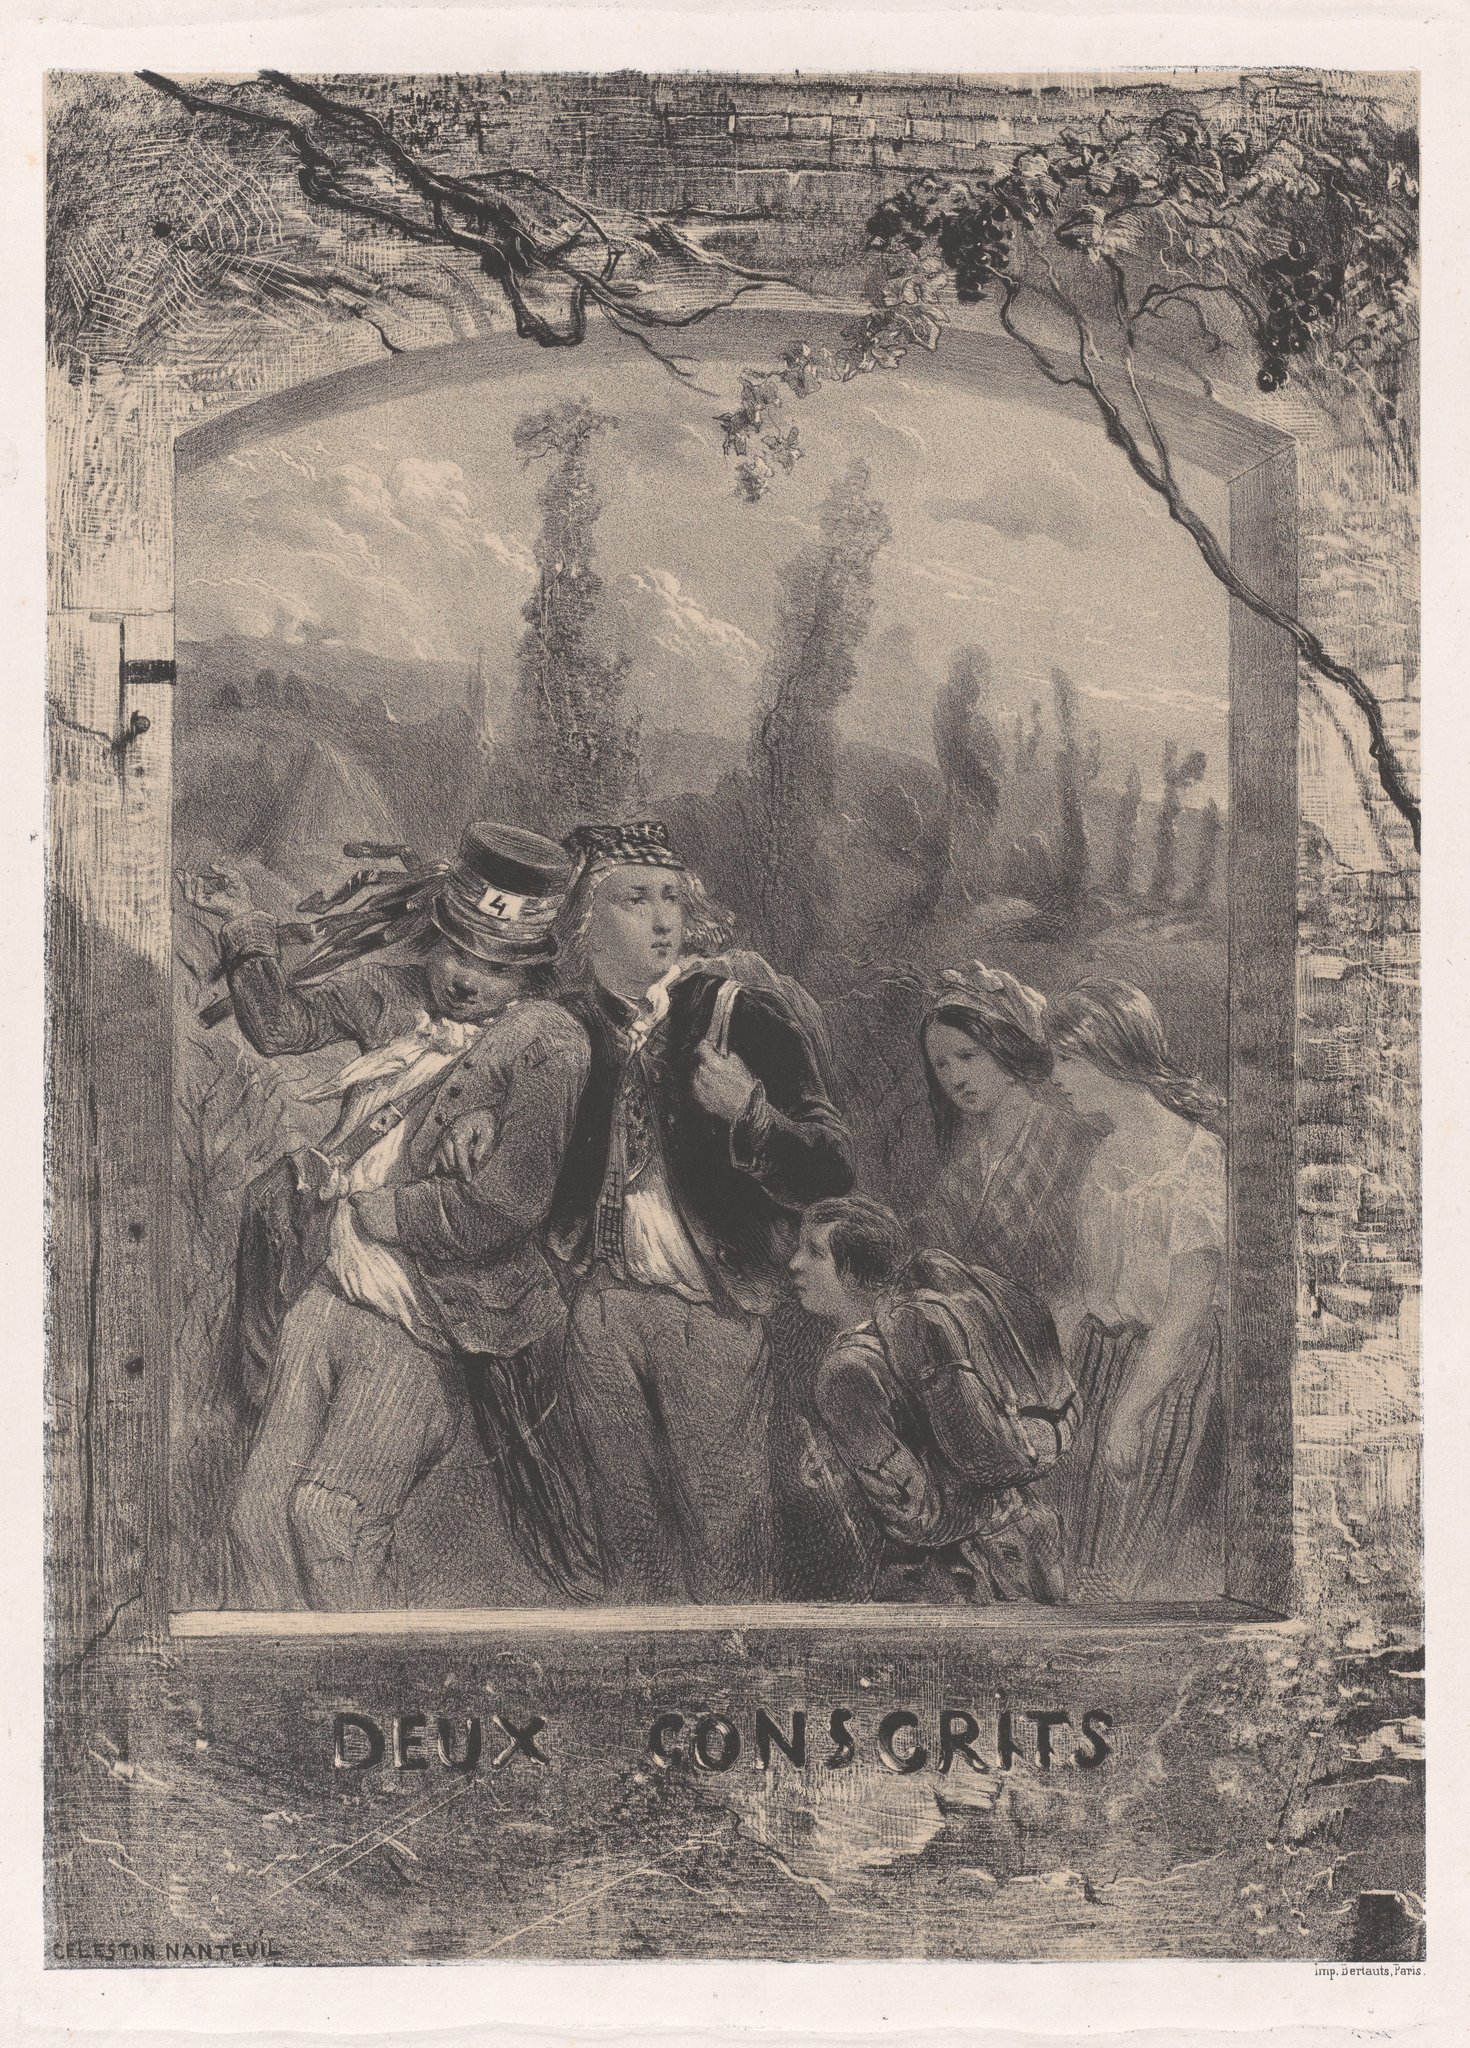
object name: print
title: Two Conscripts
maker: célestin nanteuil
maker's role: artist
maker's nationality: french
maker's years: 1813-1873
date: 1830-1870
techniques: printmaking, lithograph